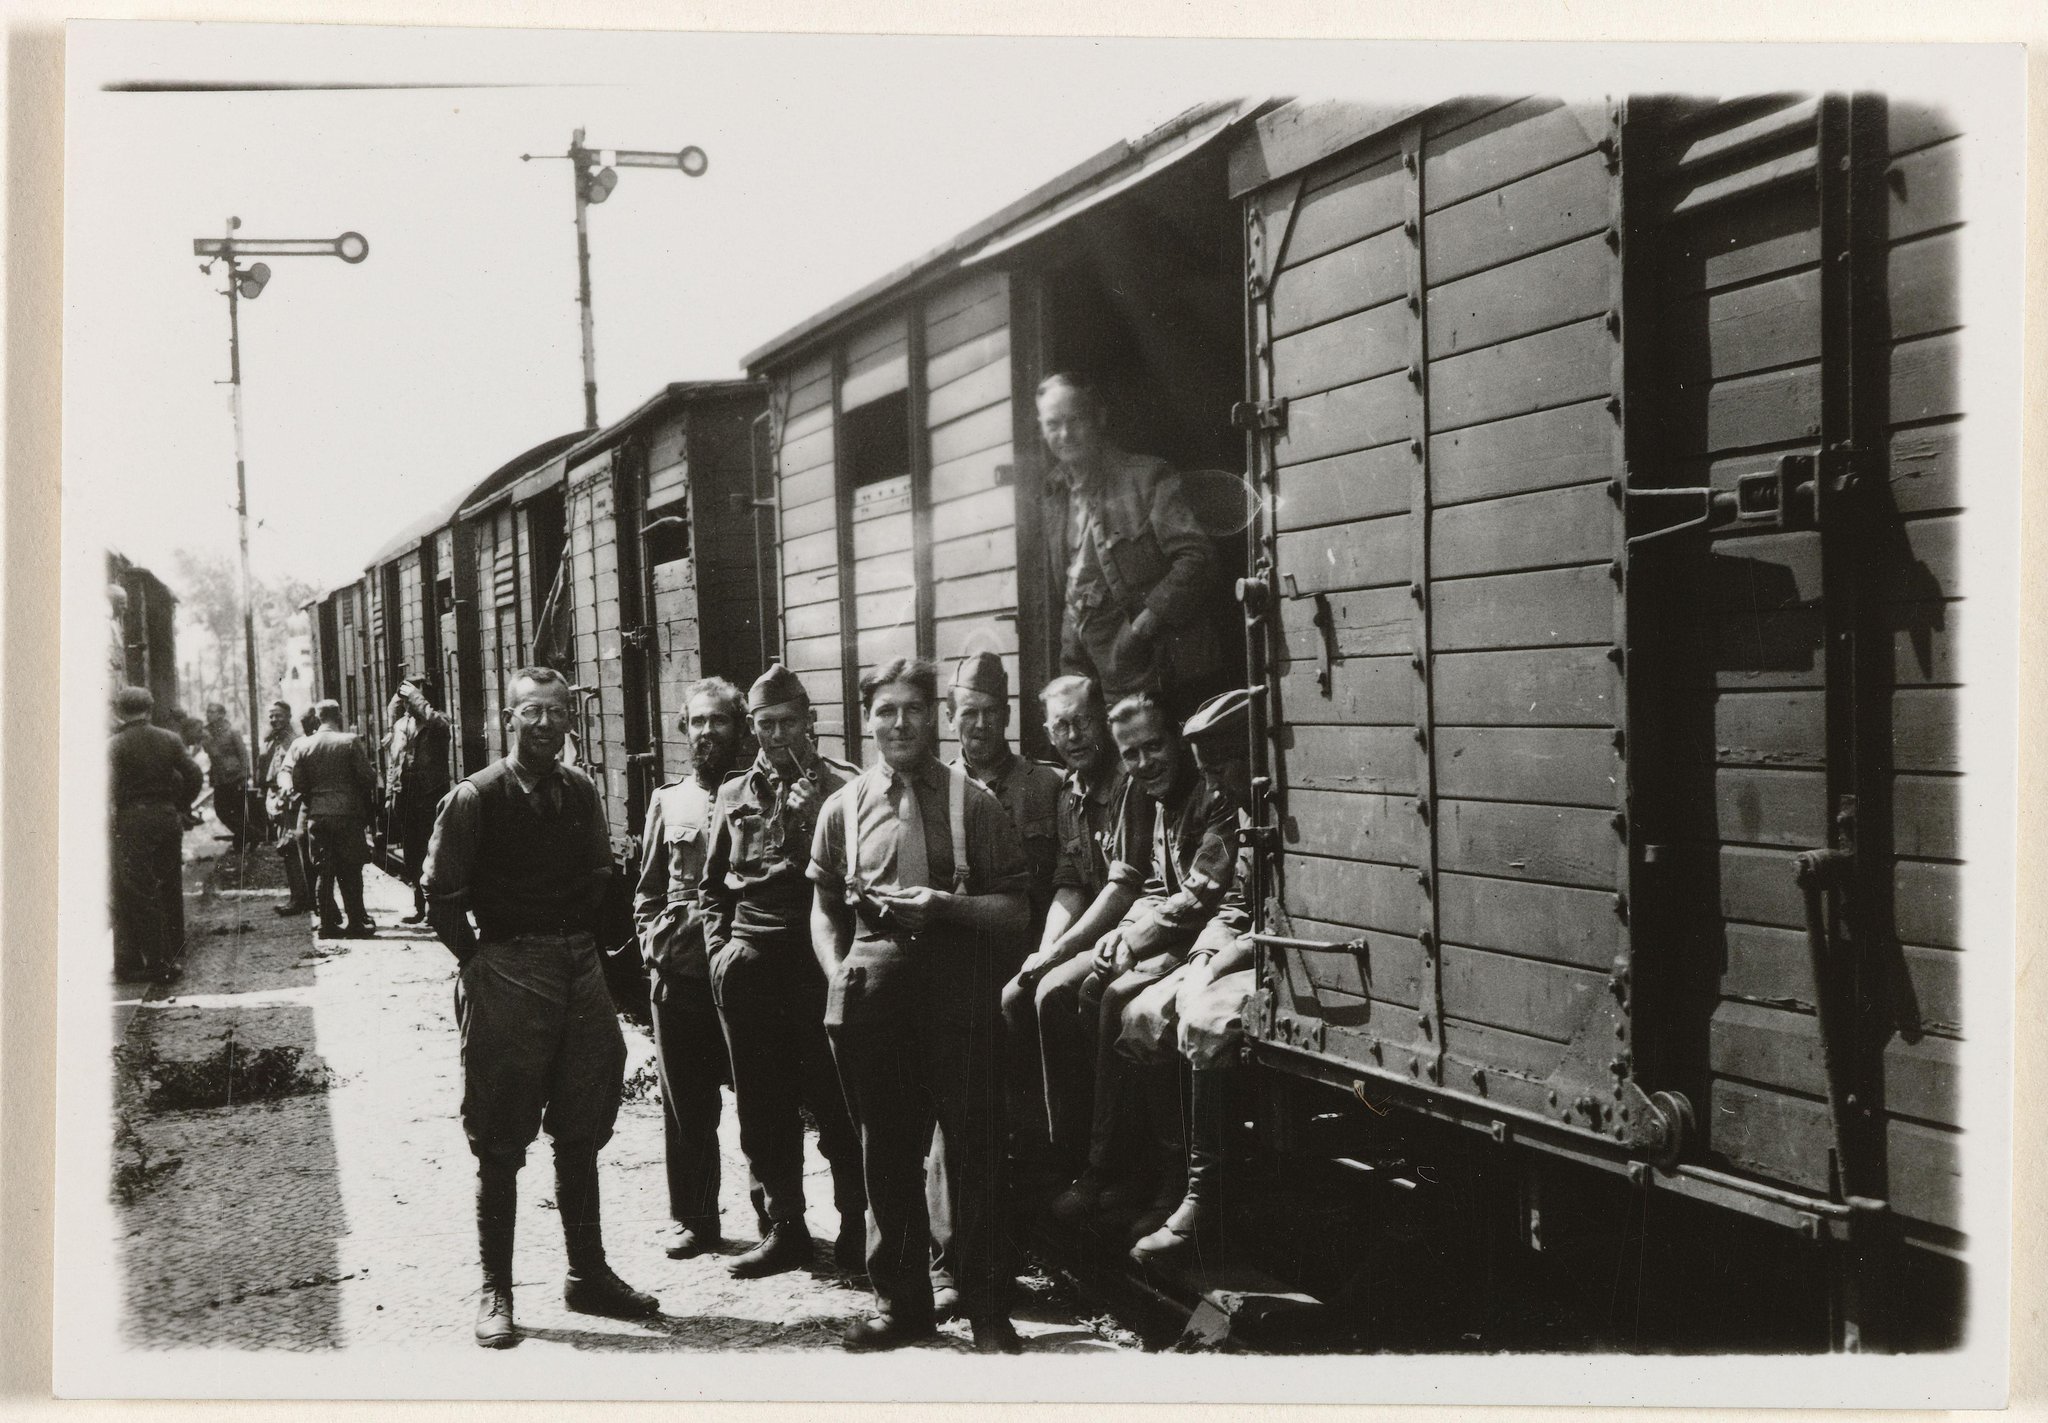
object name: photograph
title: Terug naar Nederland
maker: dick w.b. van maarseveen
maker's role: fotograaf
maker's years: 1905-1990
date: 1945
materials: photographic support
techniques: gelatin silver print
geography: muhlberg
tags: the hague, dick w.b. van maarseveen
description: Bevrijde krijgsgevangenen keren met de trein terug van kamp Mühlberg naar Nederland, mei 1945. Een groep Nederlanders poseert bij een treinwagon. Onderdeel van een groep foto's gemaakt door Dick van Maarseveen in het Duitse krijgsgevangenenkamp Stalag IV B in Mühlberg in de periode 1943-1945.